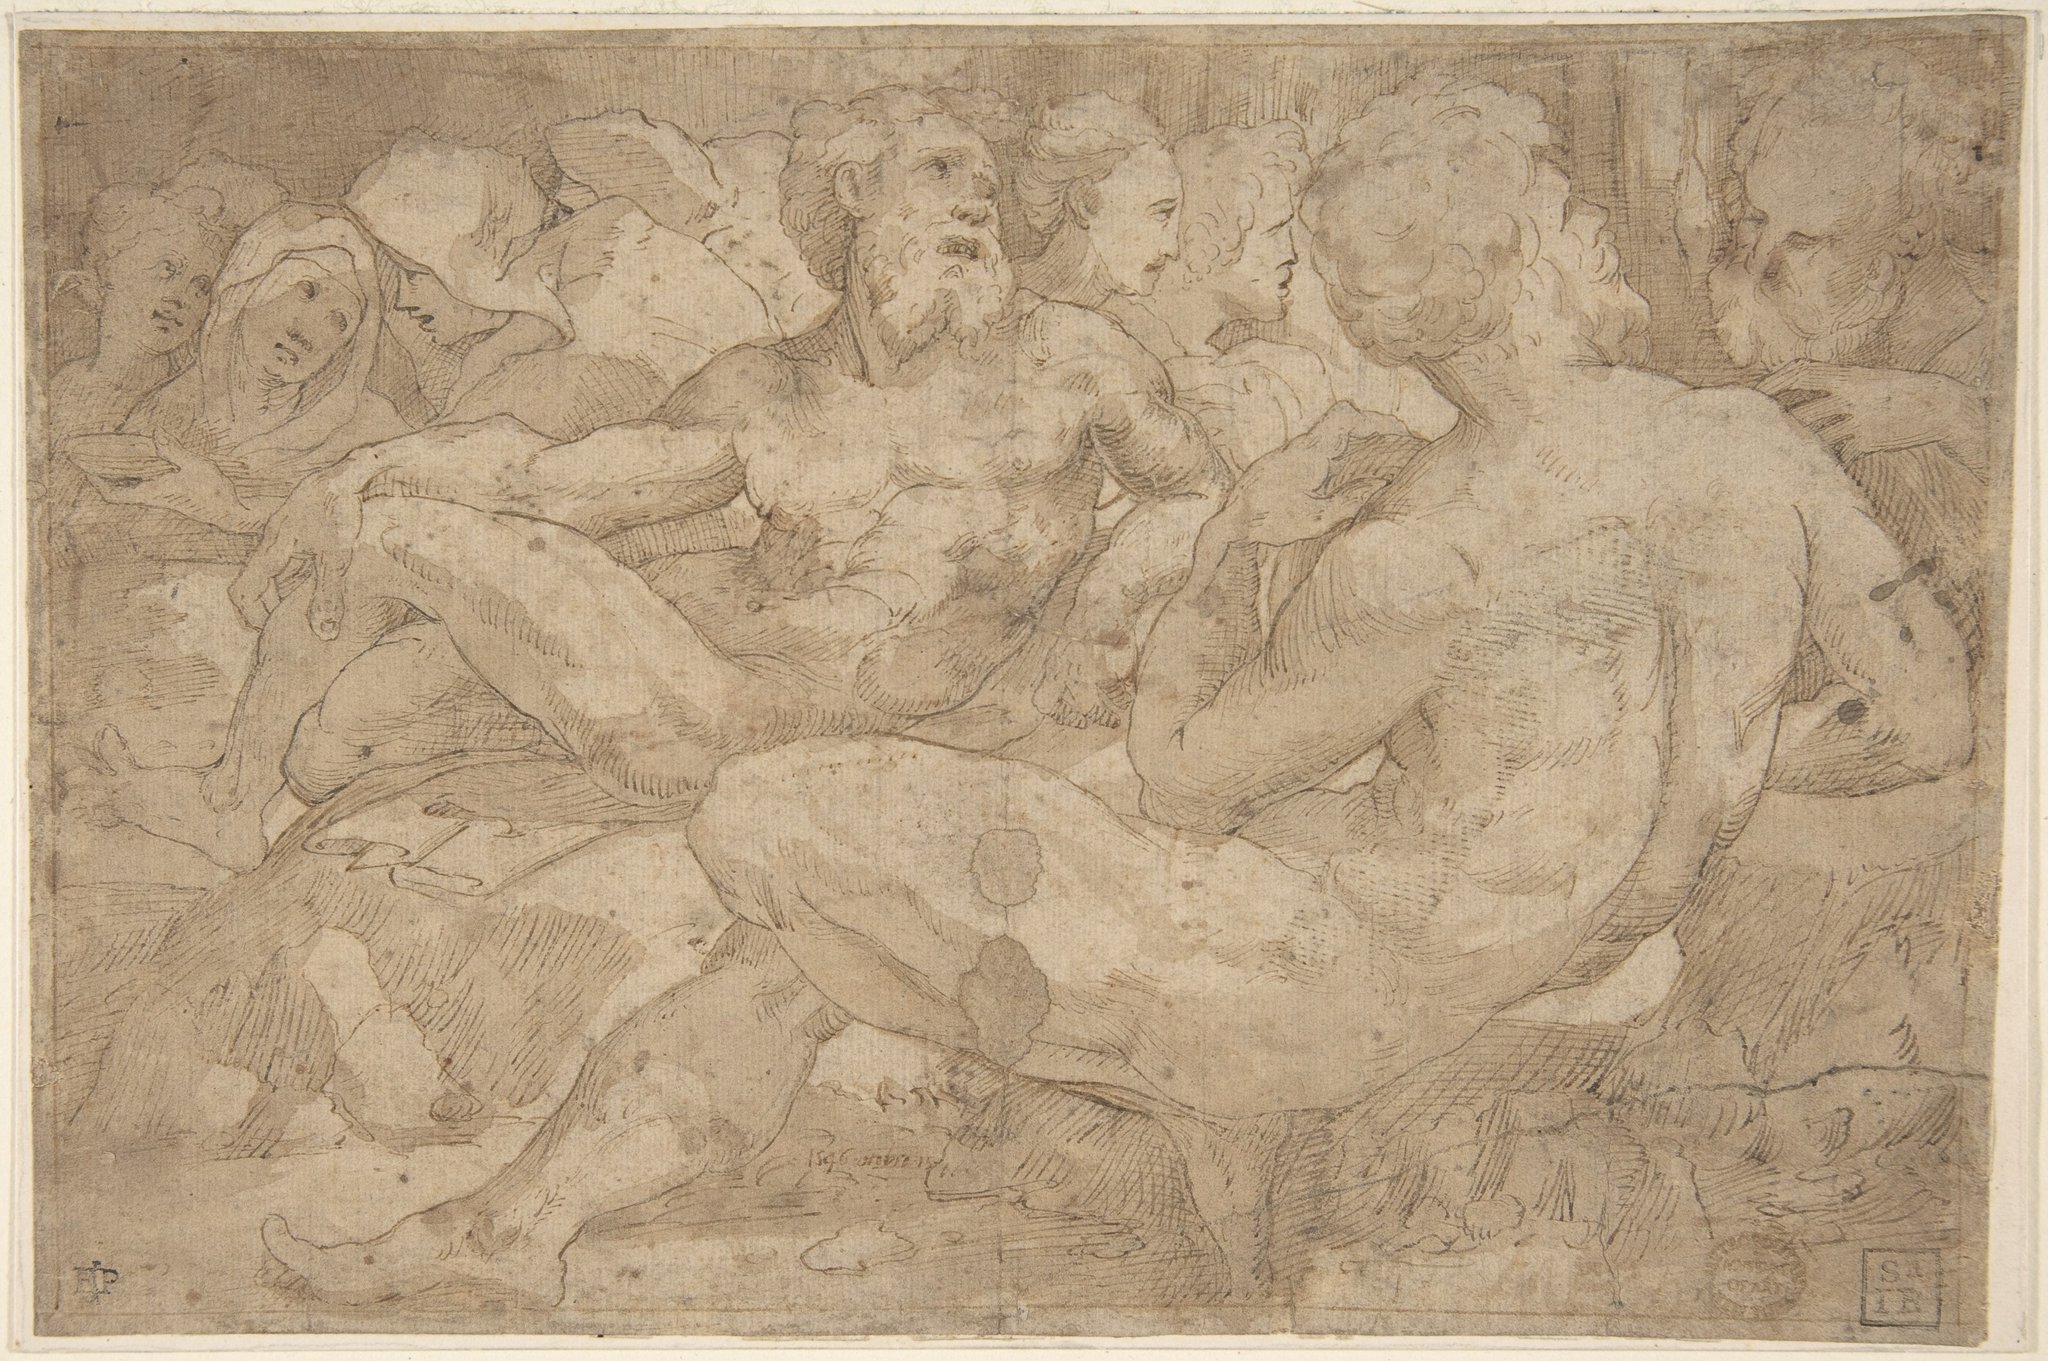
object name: drawing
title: Copy in Reverse Design Orientation: Based on the Group of Reclining Figures at Left in Domenico Beccafumi's Scene of Moses Striking the Rock in the Pavement of Siena Cathedral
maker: domenico beccafumi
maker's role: artist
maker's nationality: italian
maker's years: 1484-1551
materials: chalk, ink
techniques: brush, pen, wash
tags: male nudes,women,moses